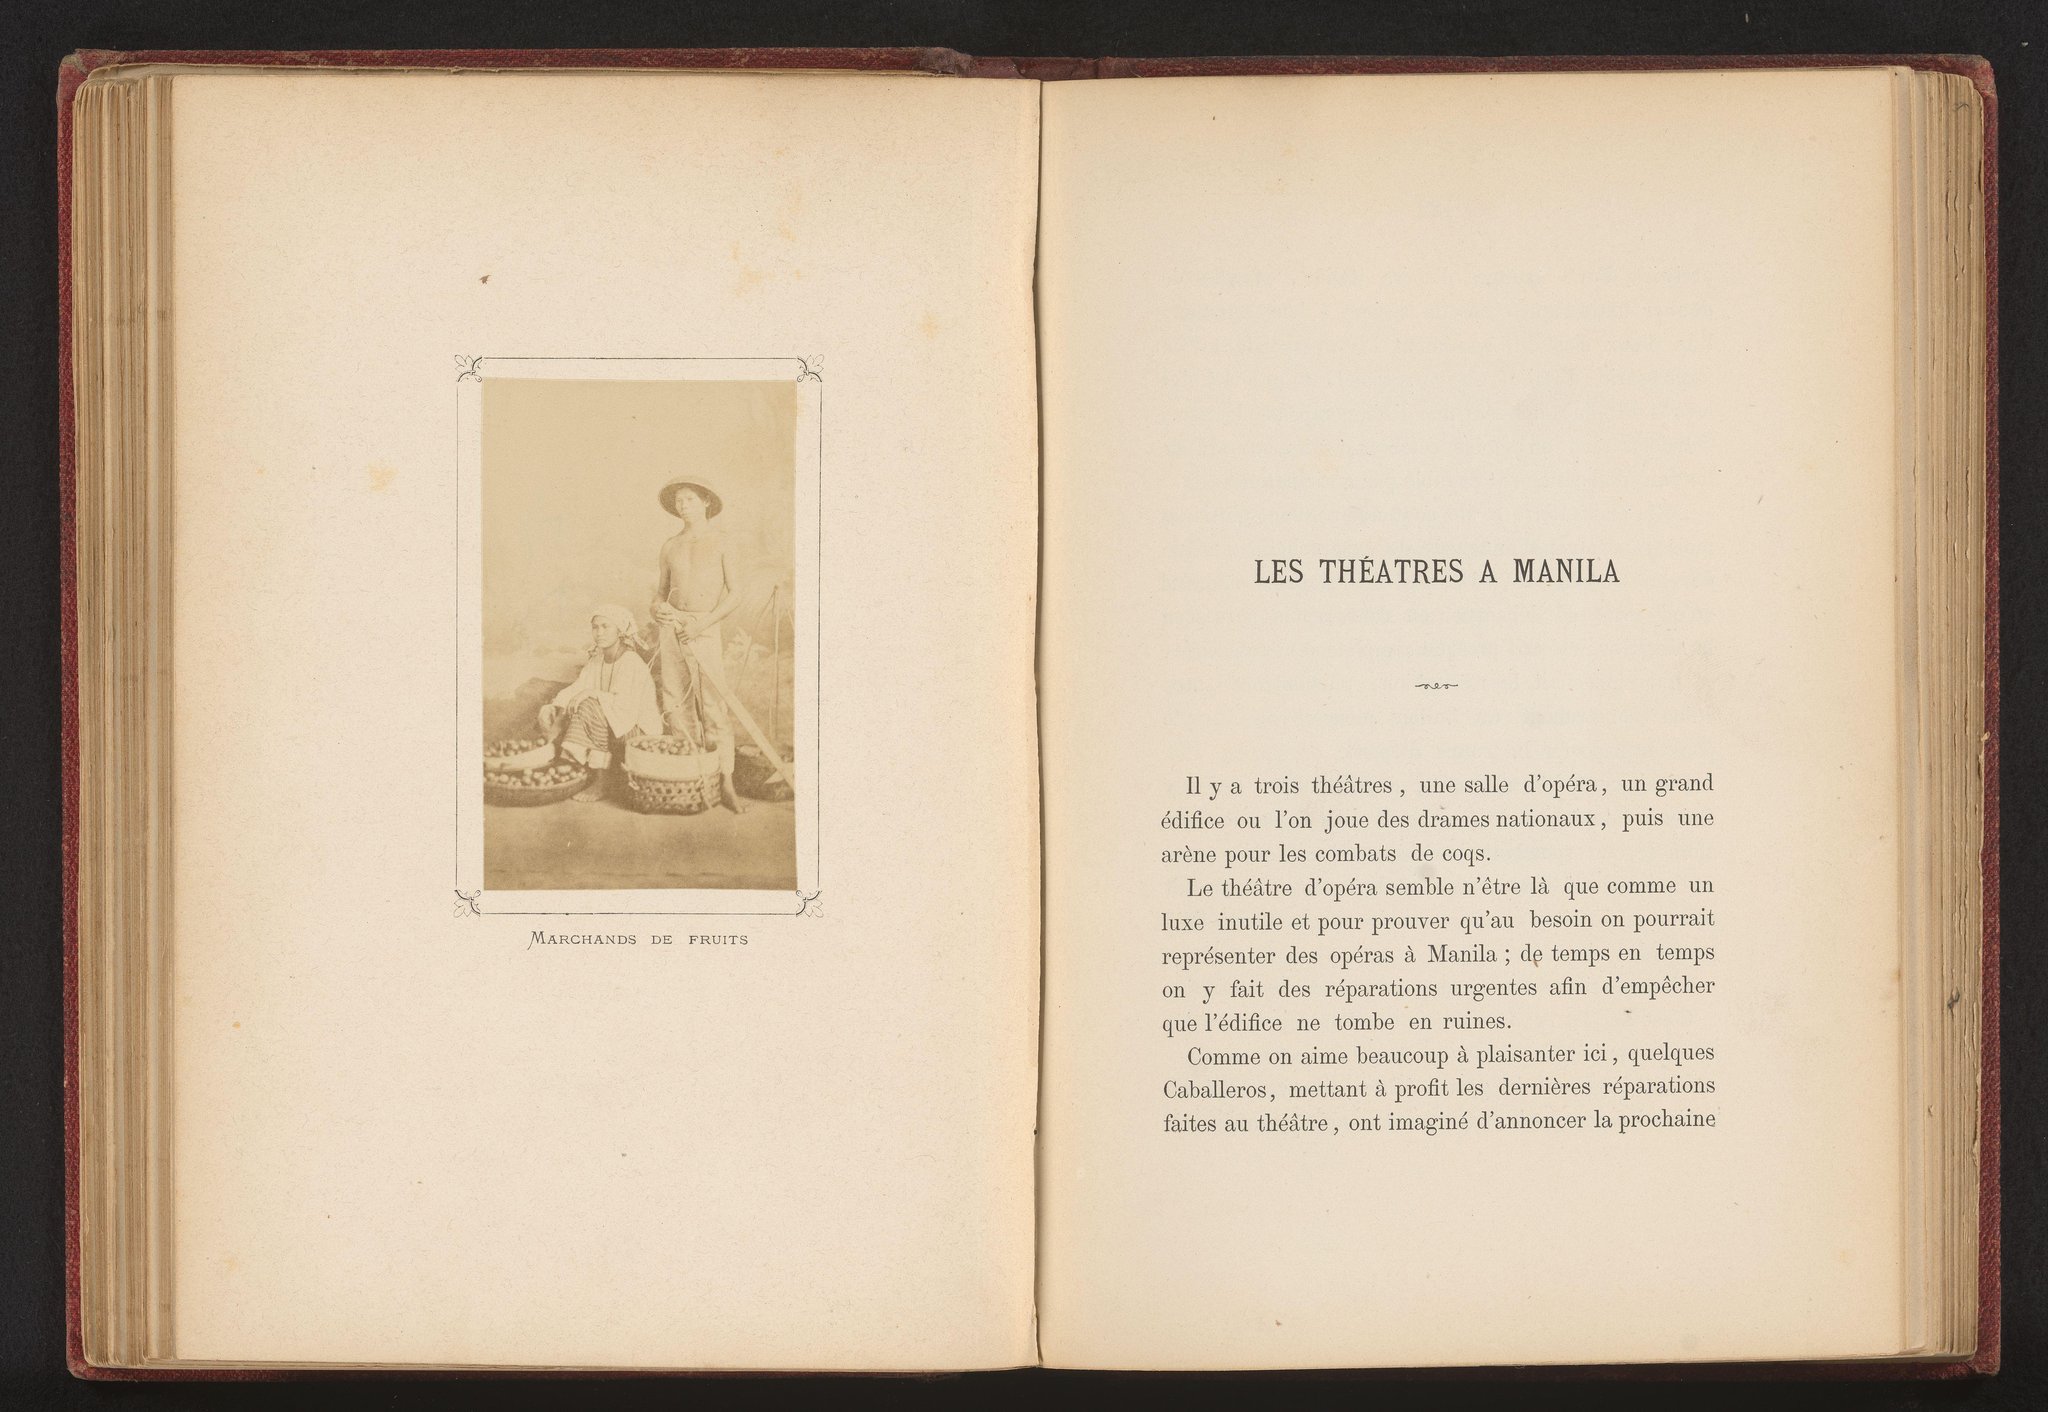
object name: photograph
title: Marchands de fruits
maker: Anonymous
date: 1865-1875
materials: paper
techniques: albumen print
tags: historical persons, fruits, merchant, salesman